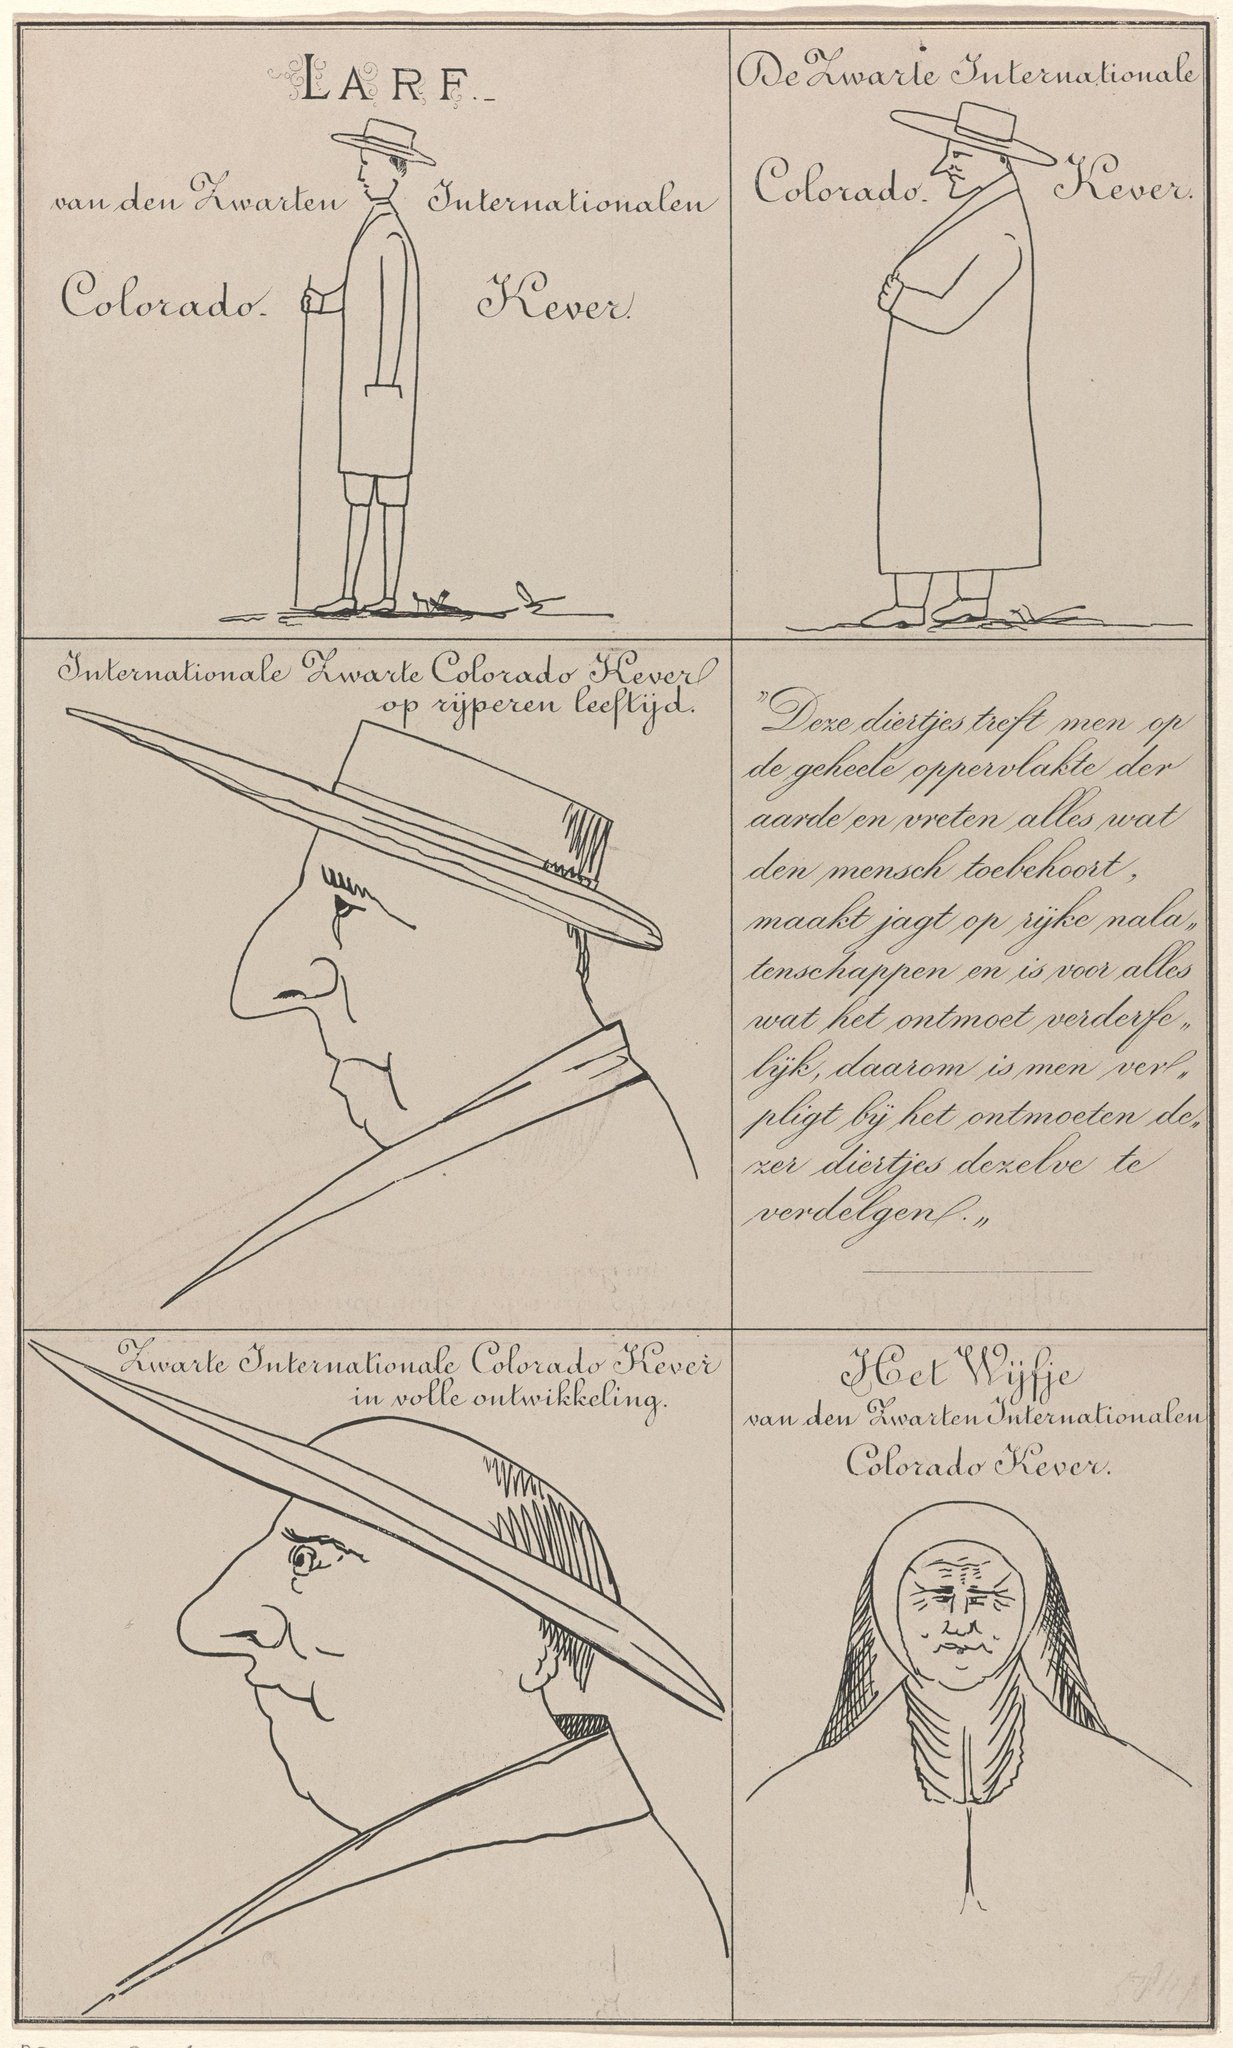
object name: cartoon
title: De Zwarte Internationale Colorado Kever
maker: Anonymous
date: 1877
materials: paper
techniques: lithograph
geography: netherlands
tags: (aspects of) christian religion or the church (as institution) ridiculed, criticized, or caricaturized, organization, functionaries and dignitaries in roman catholic church; clergy in general, insects: beetle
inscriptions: collector's mark: Lugt 2228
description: Spotprent van 1877 waarin de groei van de rooms-katholieke geestelijke van 'larf tot volle ontwikkeling' wordt vergeleken met die van de coloradokever. Blad verdeeld in zes compartimenten met vijf voorstellingen en een tekstdeel. De coloradokever werd in 1877 voor het eerst in Europa gesignaleerd.